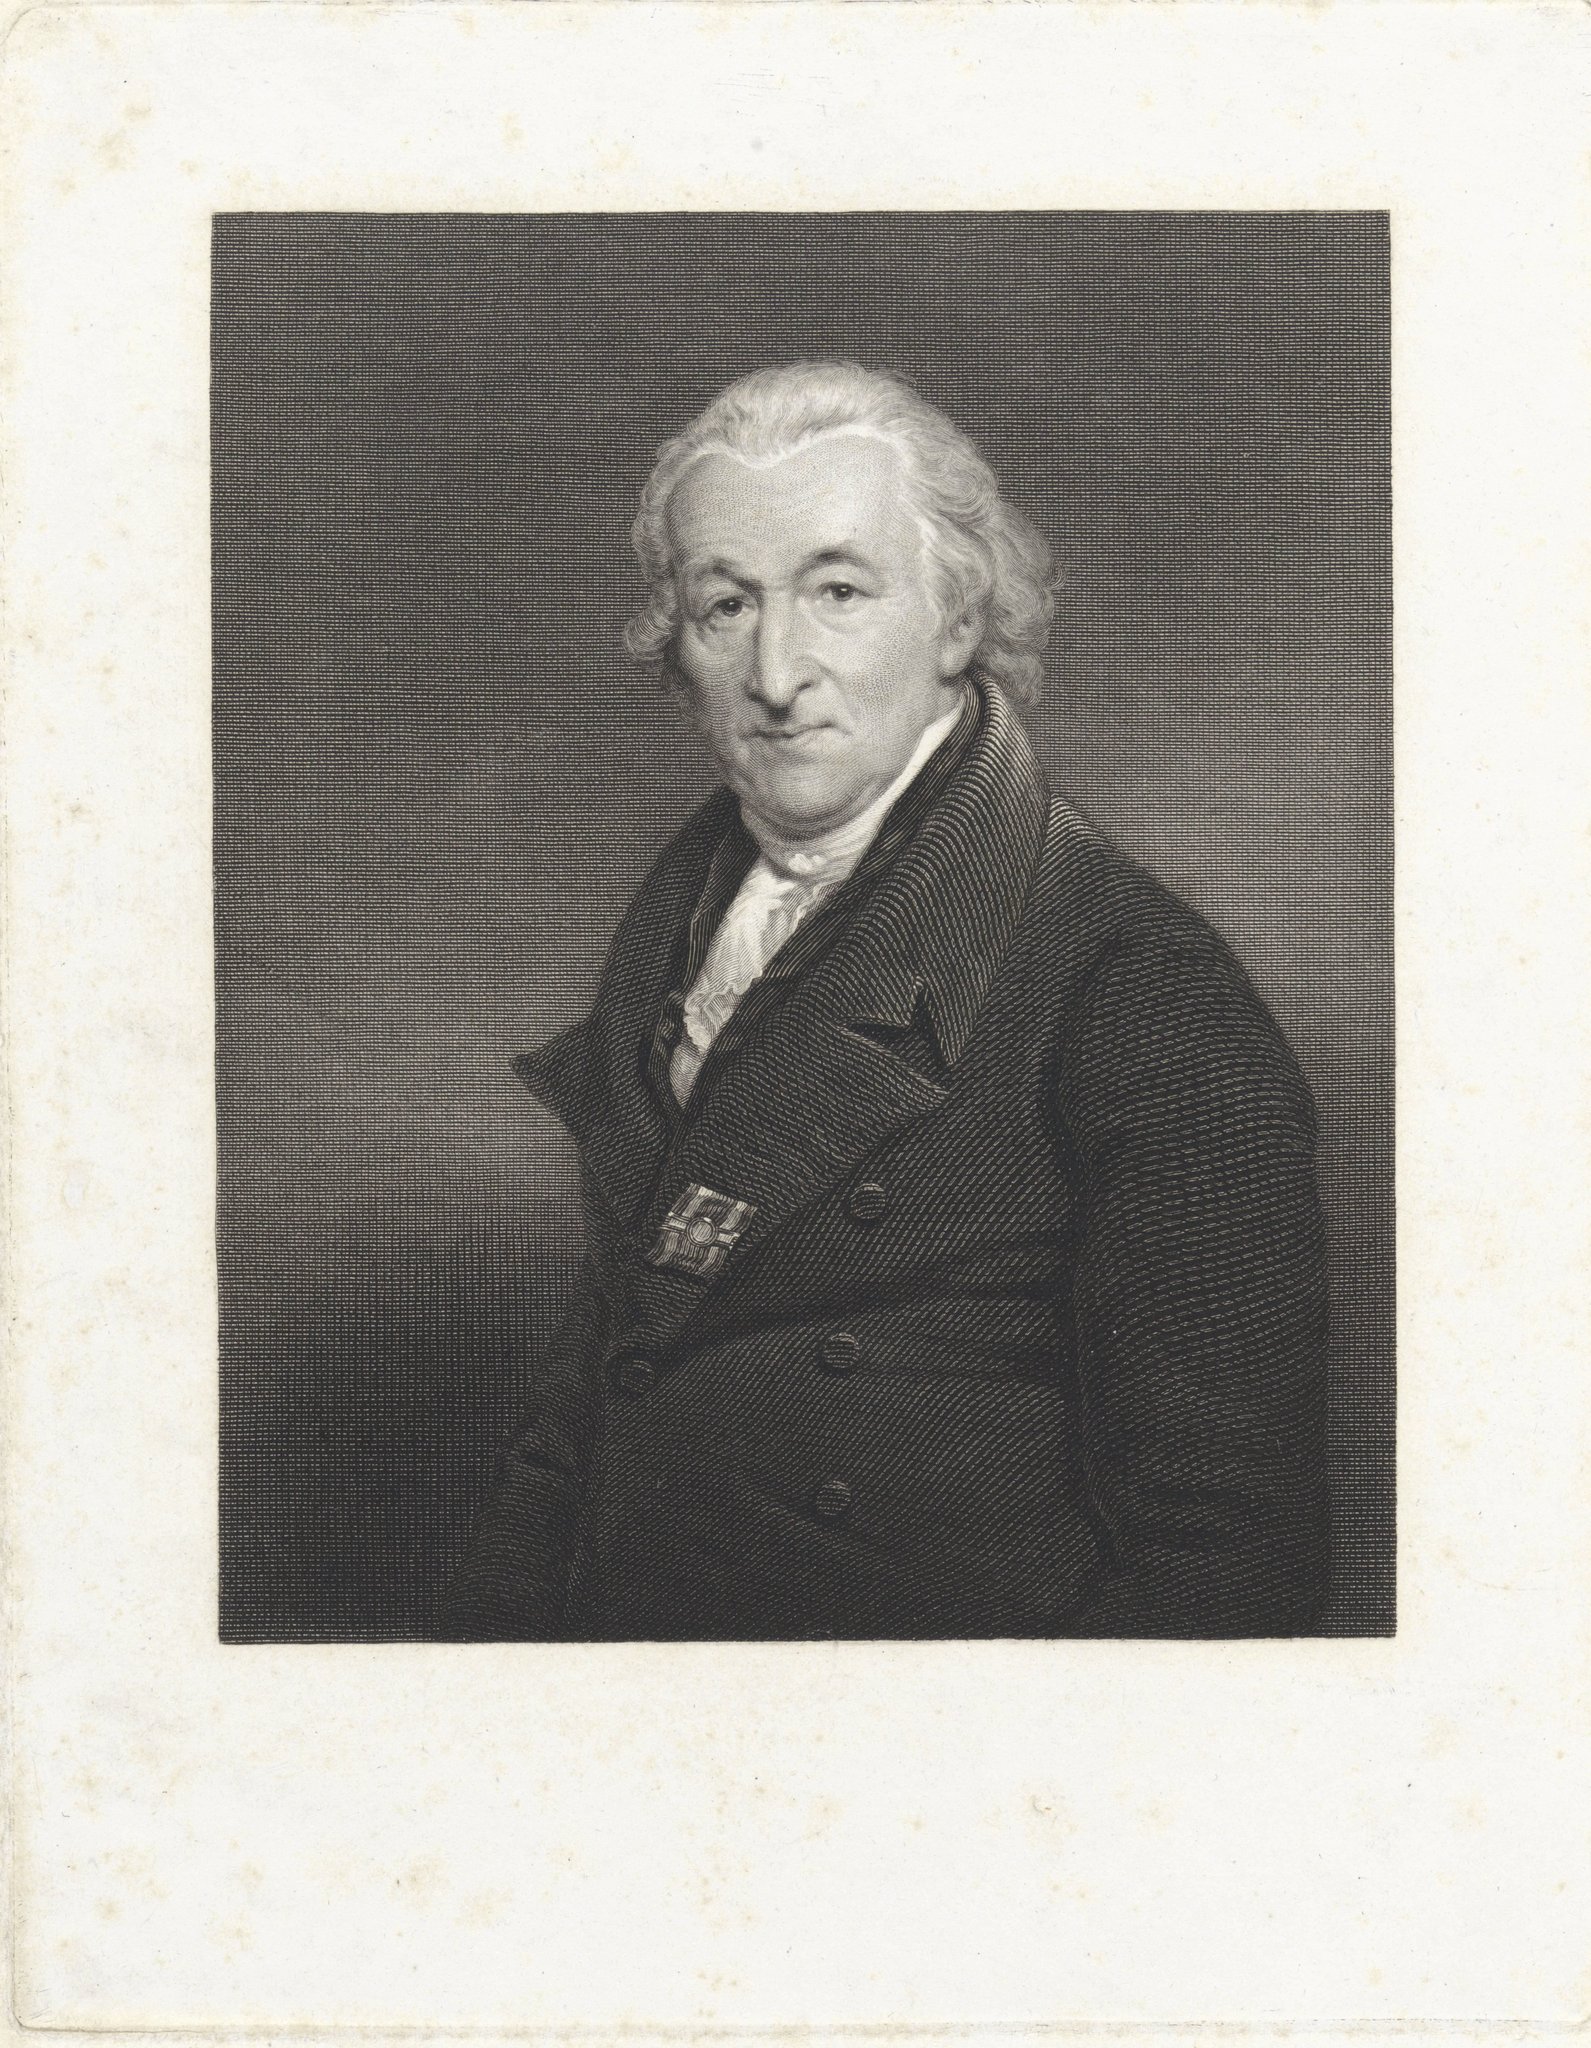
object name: print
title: Portret van Martinus van Marum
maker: willem van senus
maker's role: painter, print maker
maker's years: 1773-1851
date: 1830-1832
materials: paper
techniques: engraving, etching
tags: delft, haarlem, physicist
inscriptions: collector's mark: Lugt 2228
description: Portret van de schei- en natuurkundige Martinus van Marum.